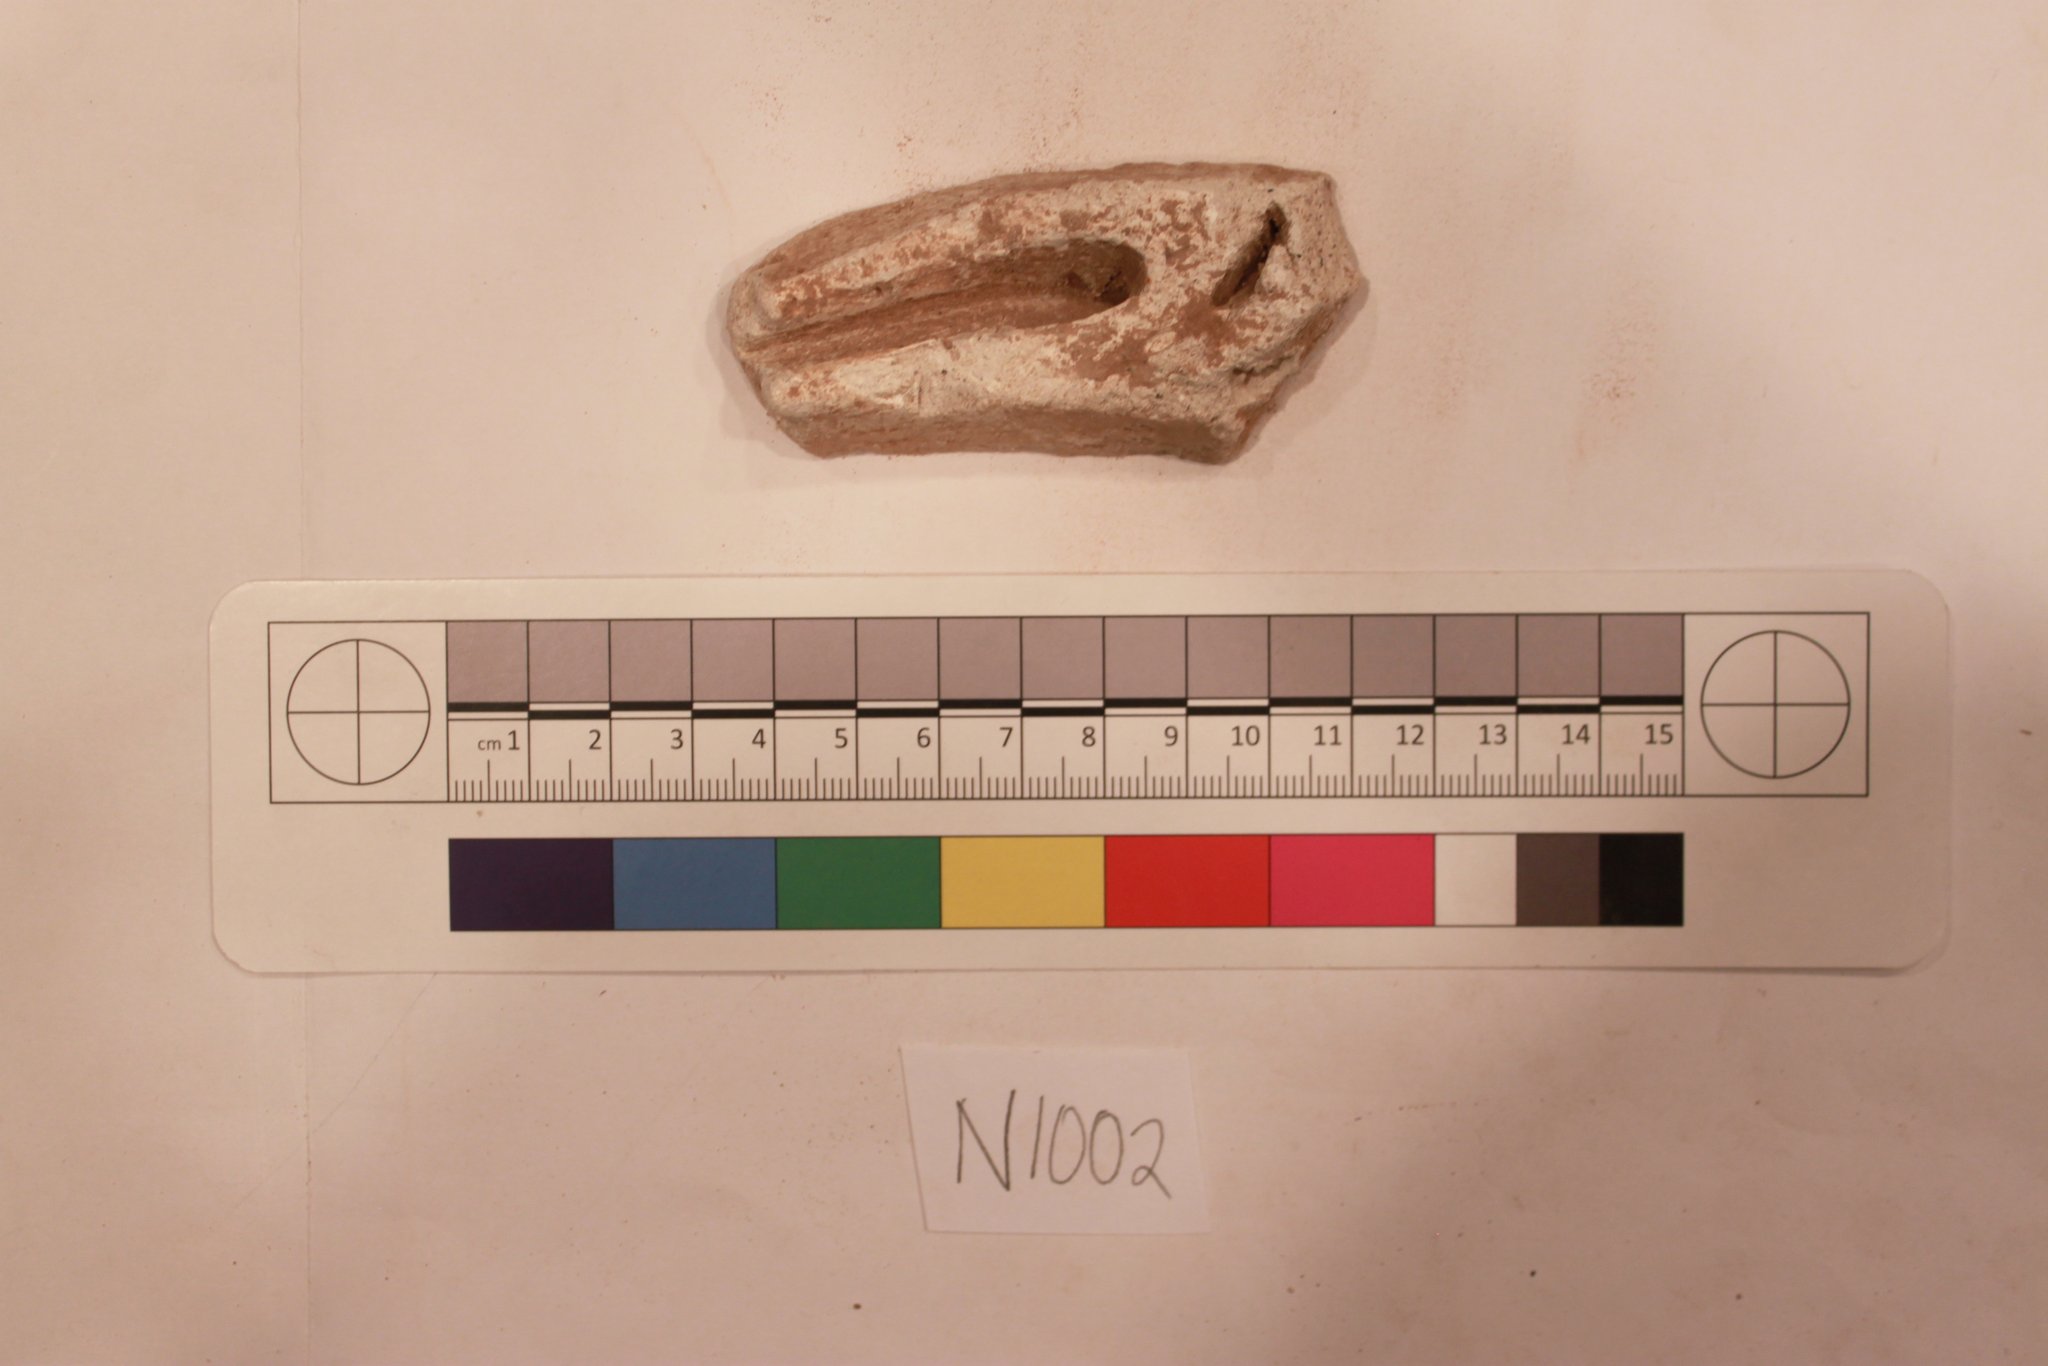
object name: fragment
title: Stucco Fragment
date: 701-1200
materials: plaster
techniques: carving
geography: iran